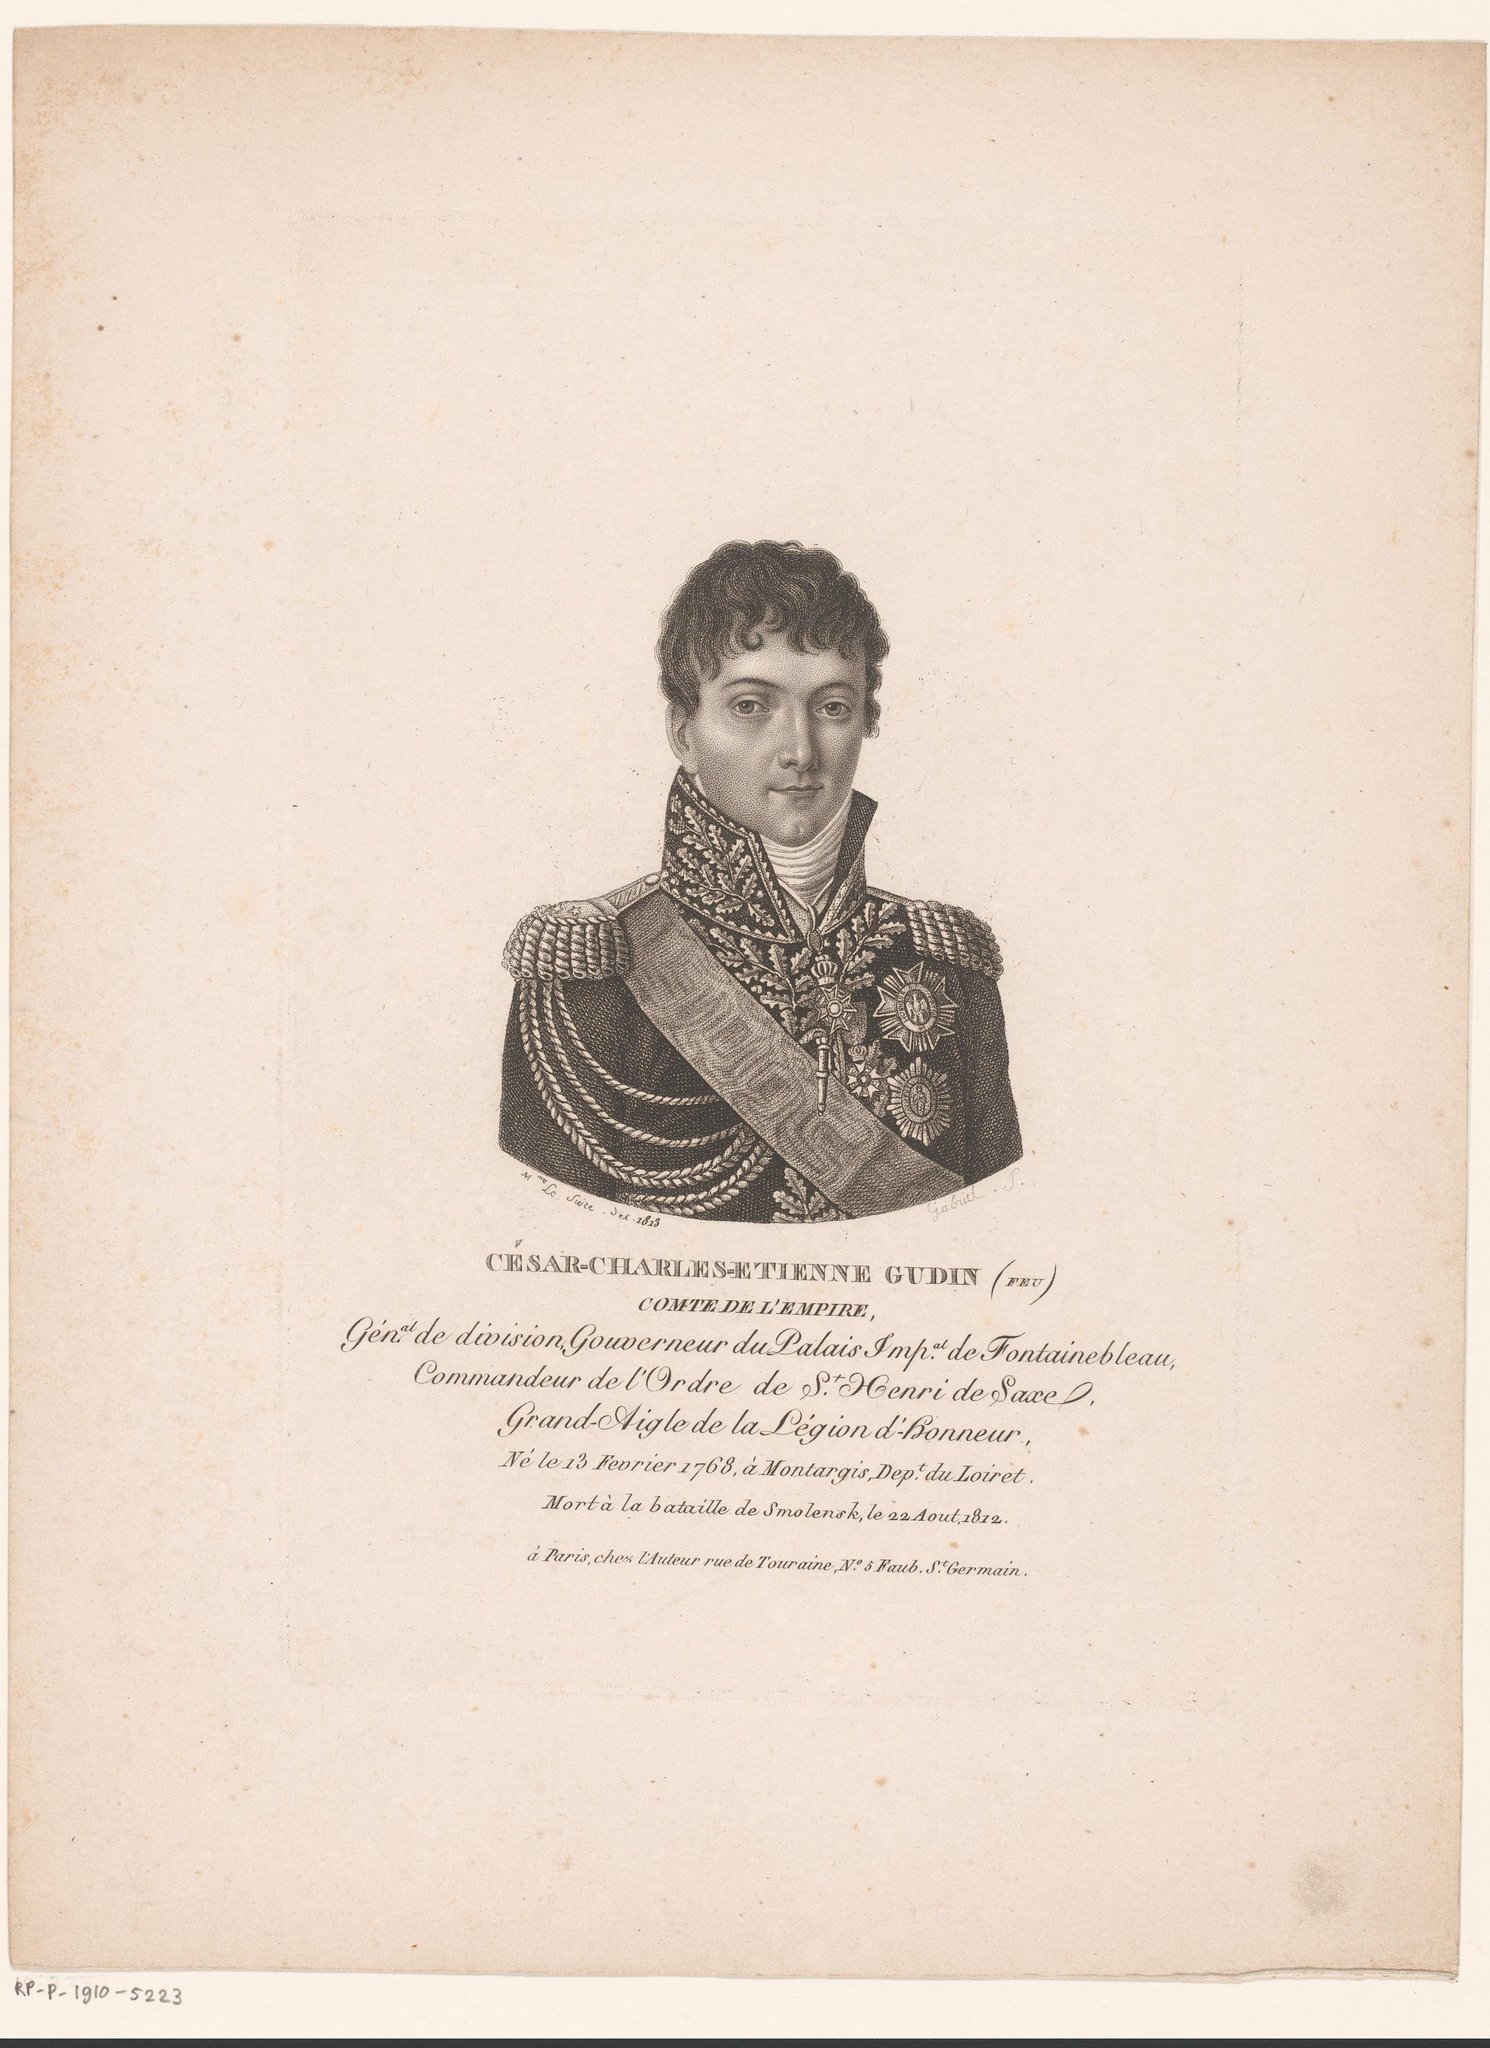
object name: print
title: Portret van Charles-Étienne Gudin de La Sablonnière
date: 1813-1846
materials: paper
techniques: etching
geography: paris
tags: commander-in-chief, general, marshal, historical persons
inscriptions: collector's mark: Lugt 2228